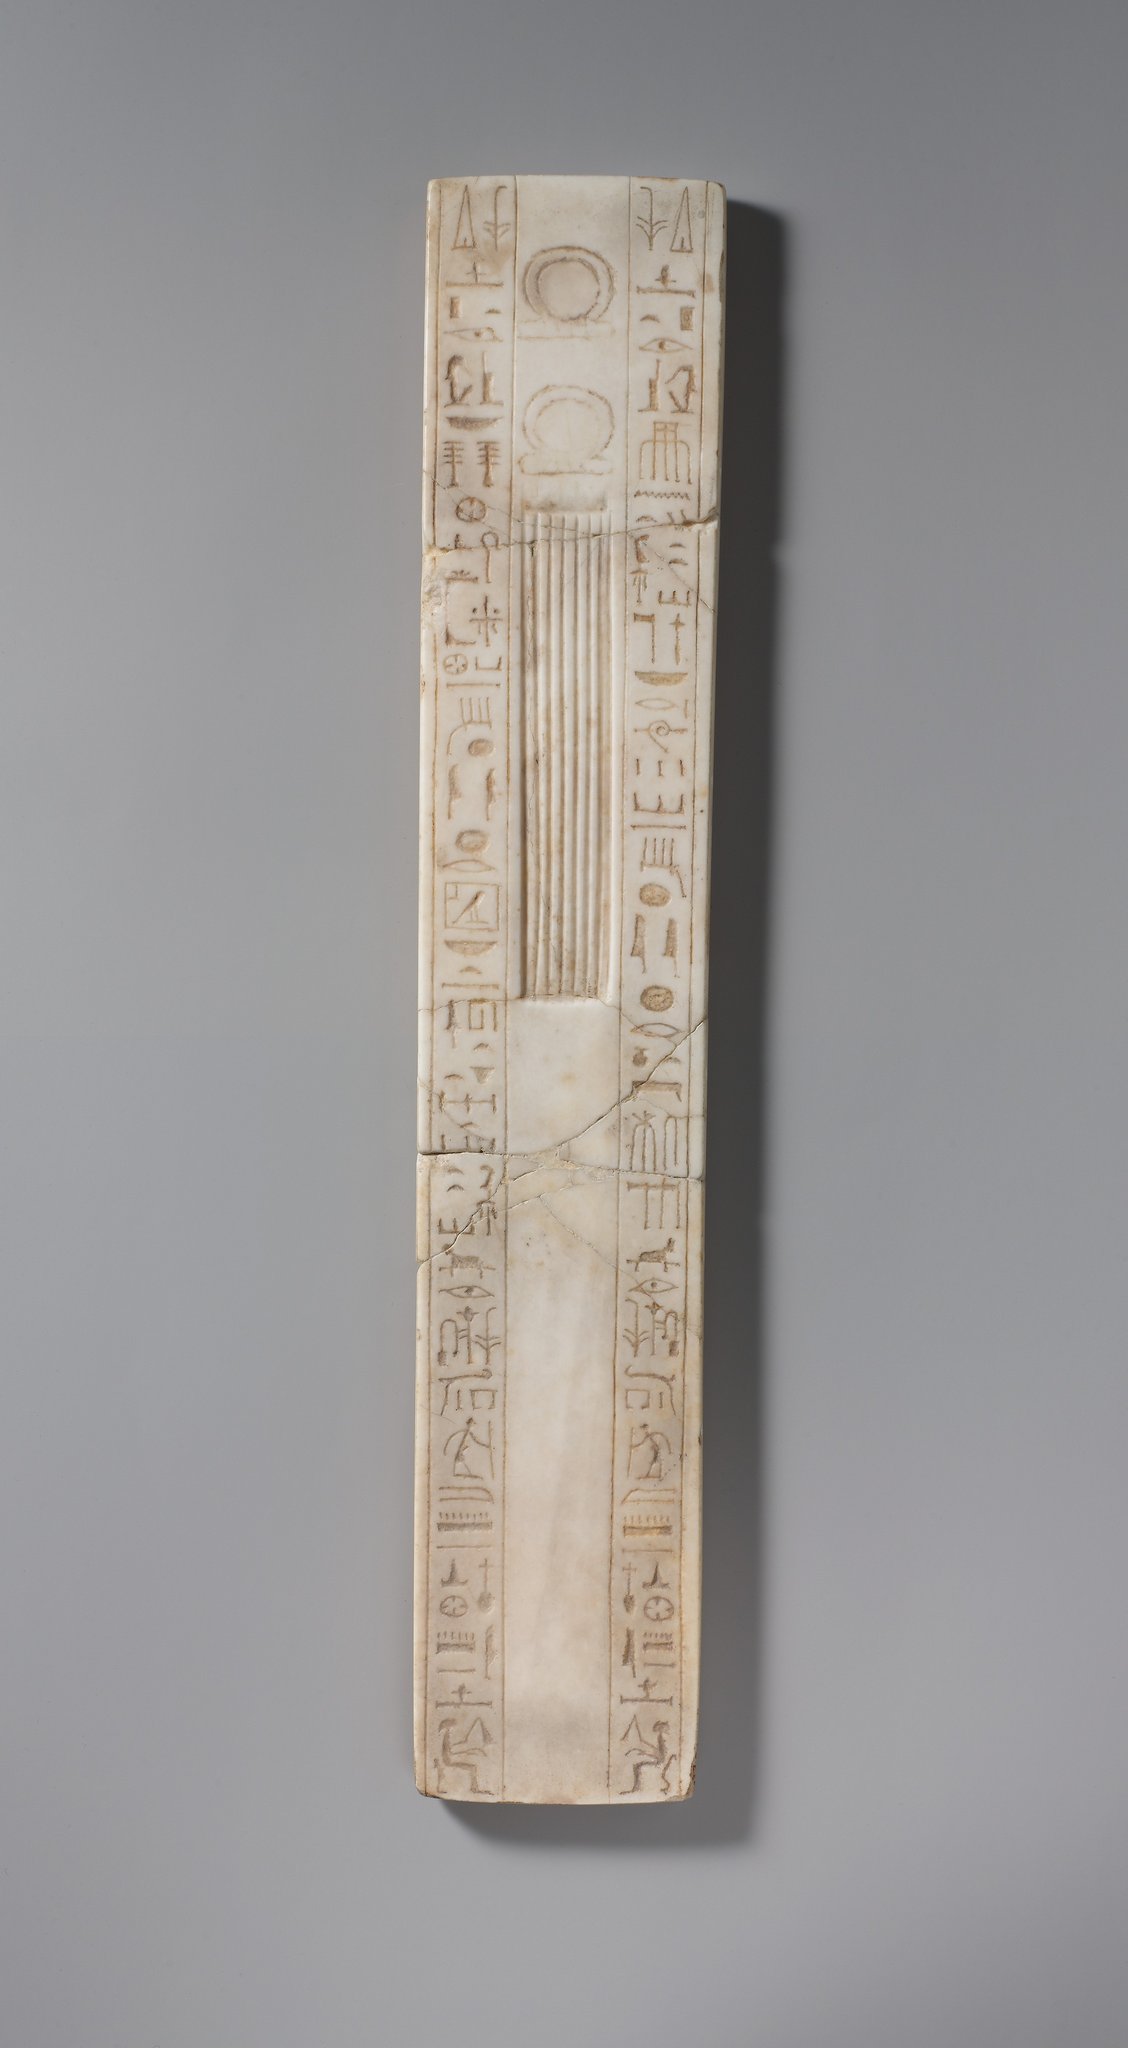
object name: model palette, amenhotep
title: Model of a Scribe's Palette Inscribed for Amenhotep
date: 1390-1352 BCE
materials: stone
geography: memphite area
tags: hieroglyphs